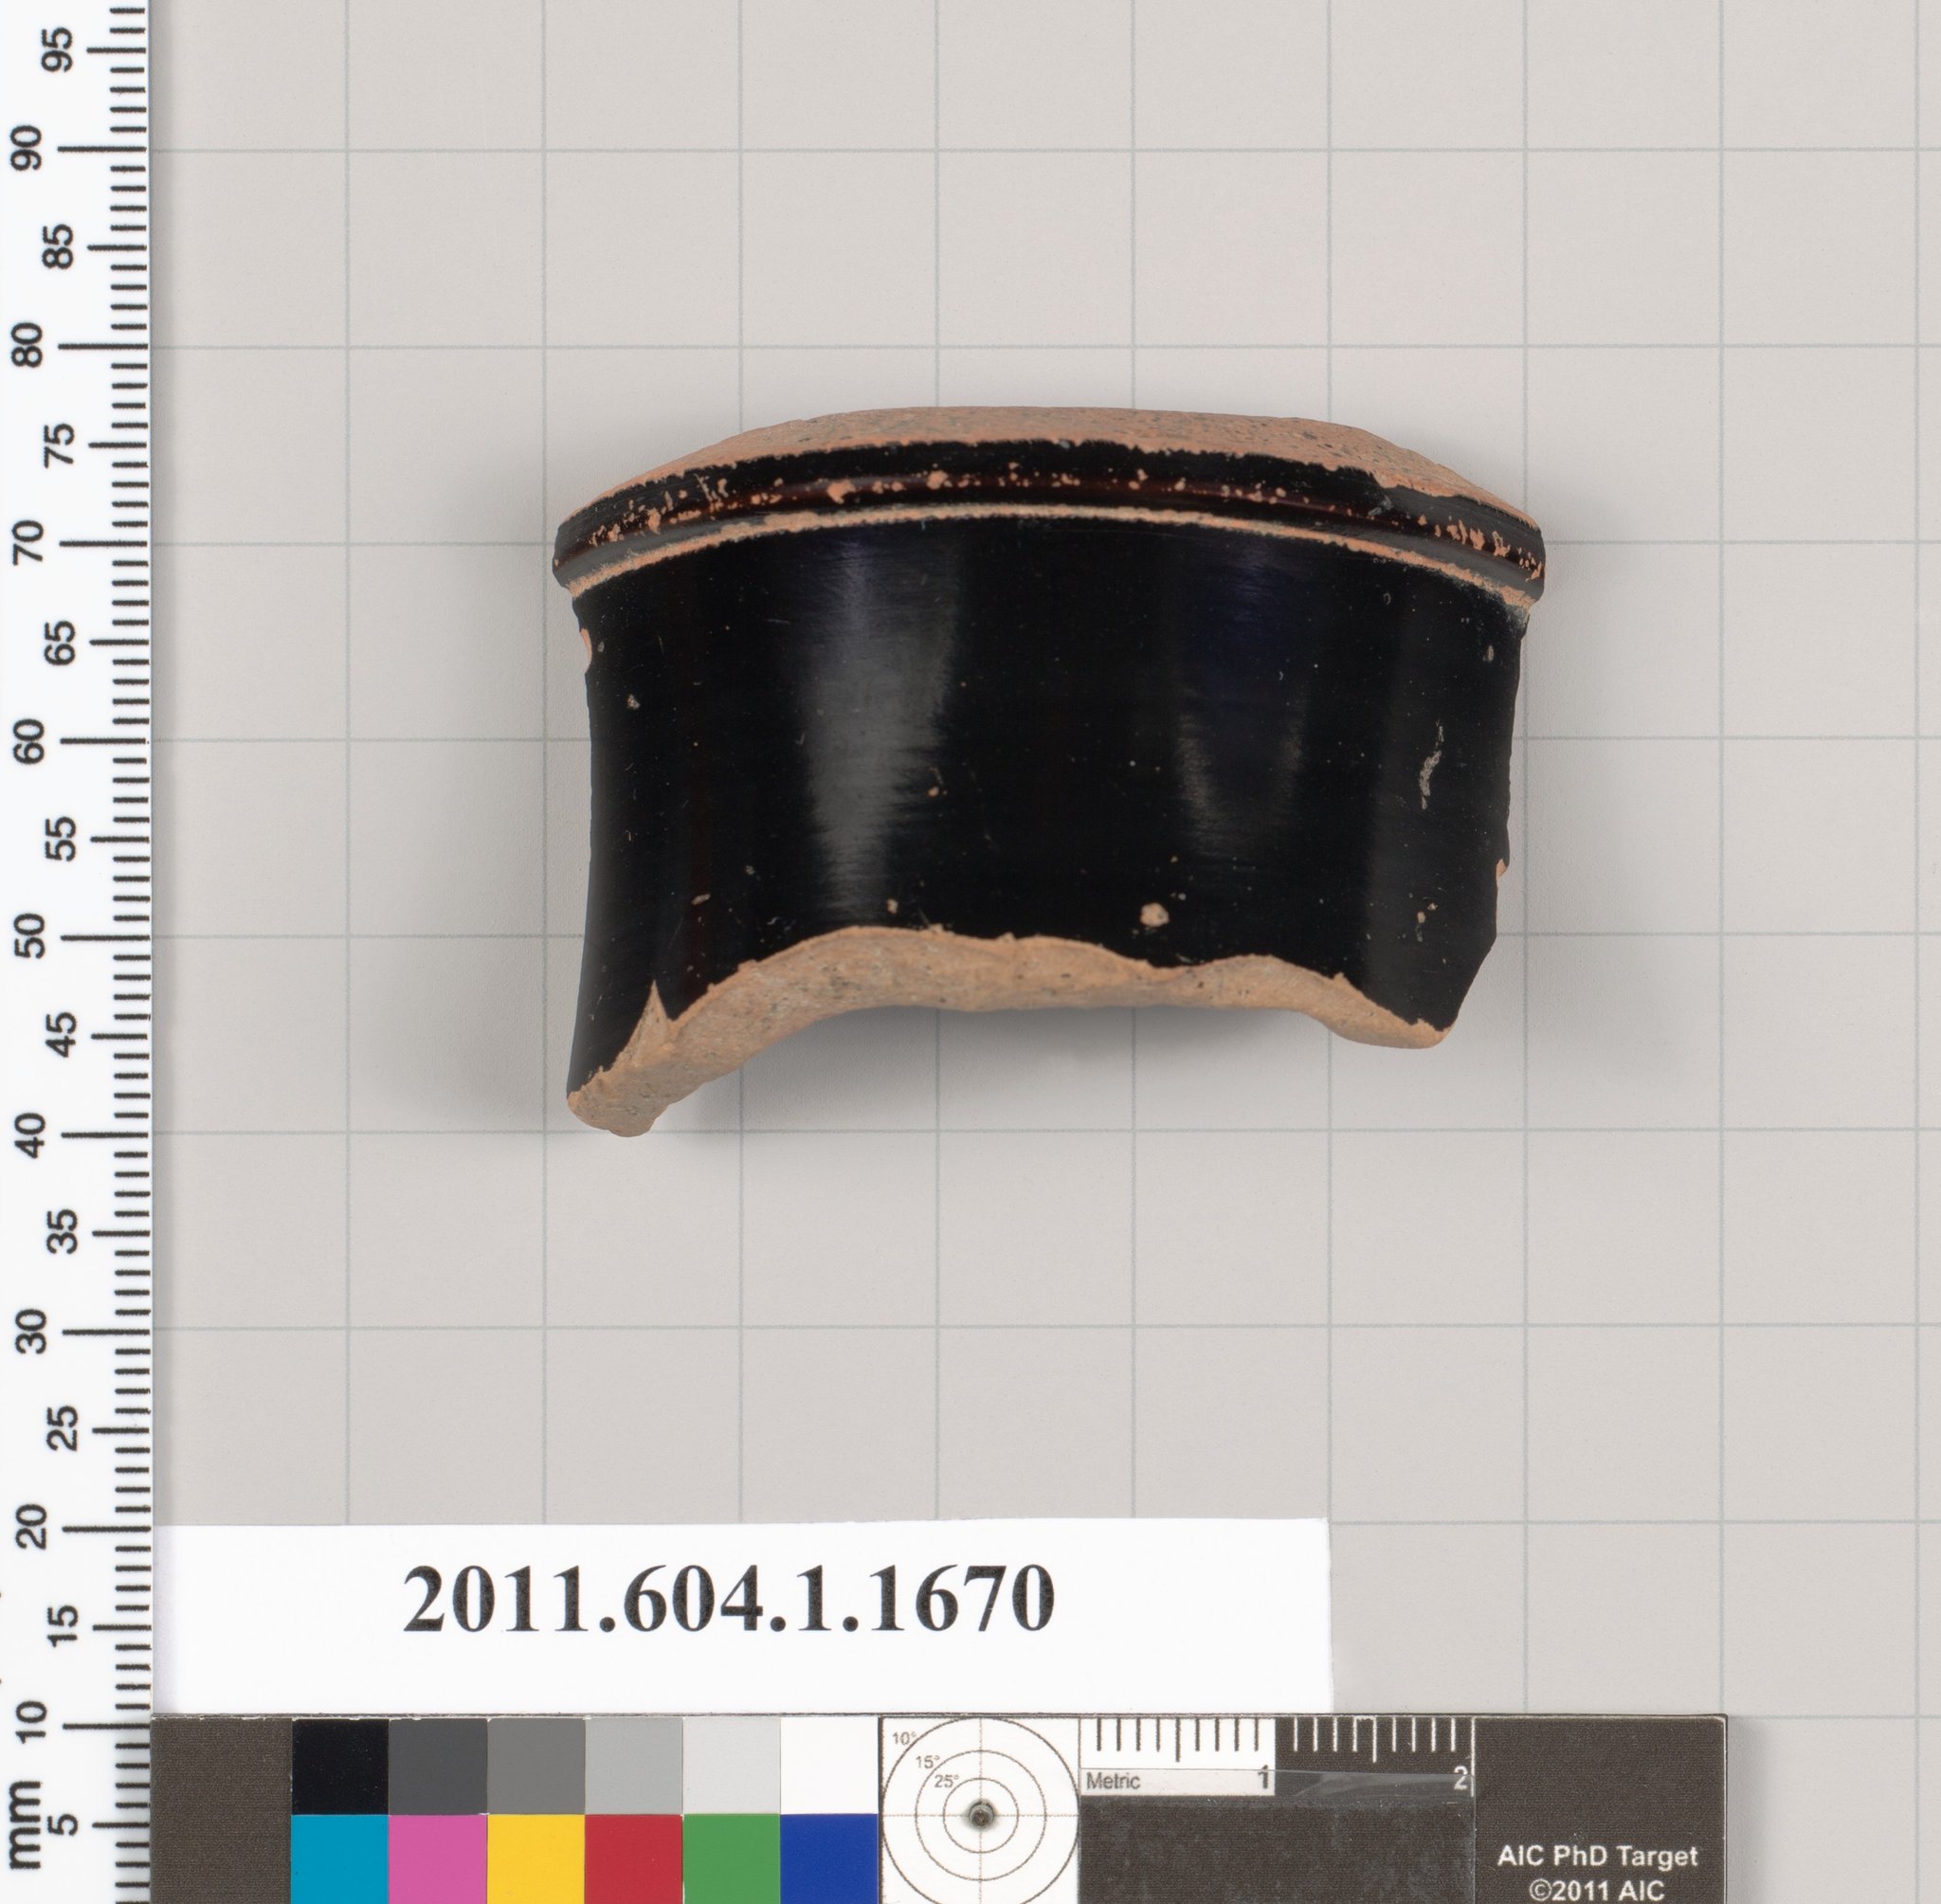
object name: kylix fragment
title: Terracotta fragment of a kylix (drinking cup)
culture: greek, attic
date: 534-468 BCE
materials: terracotta